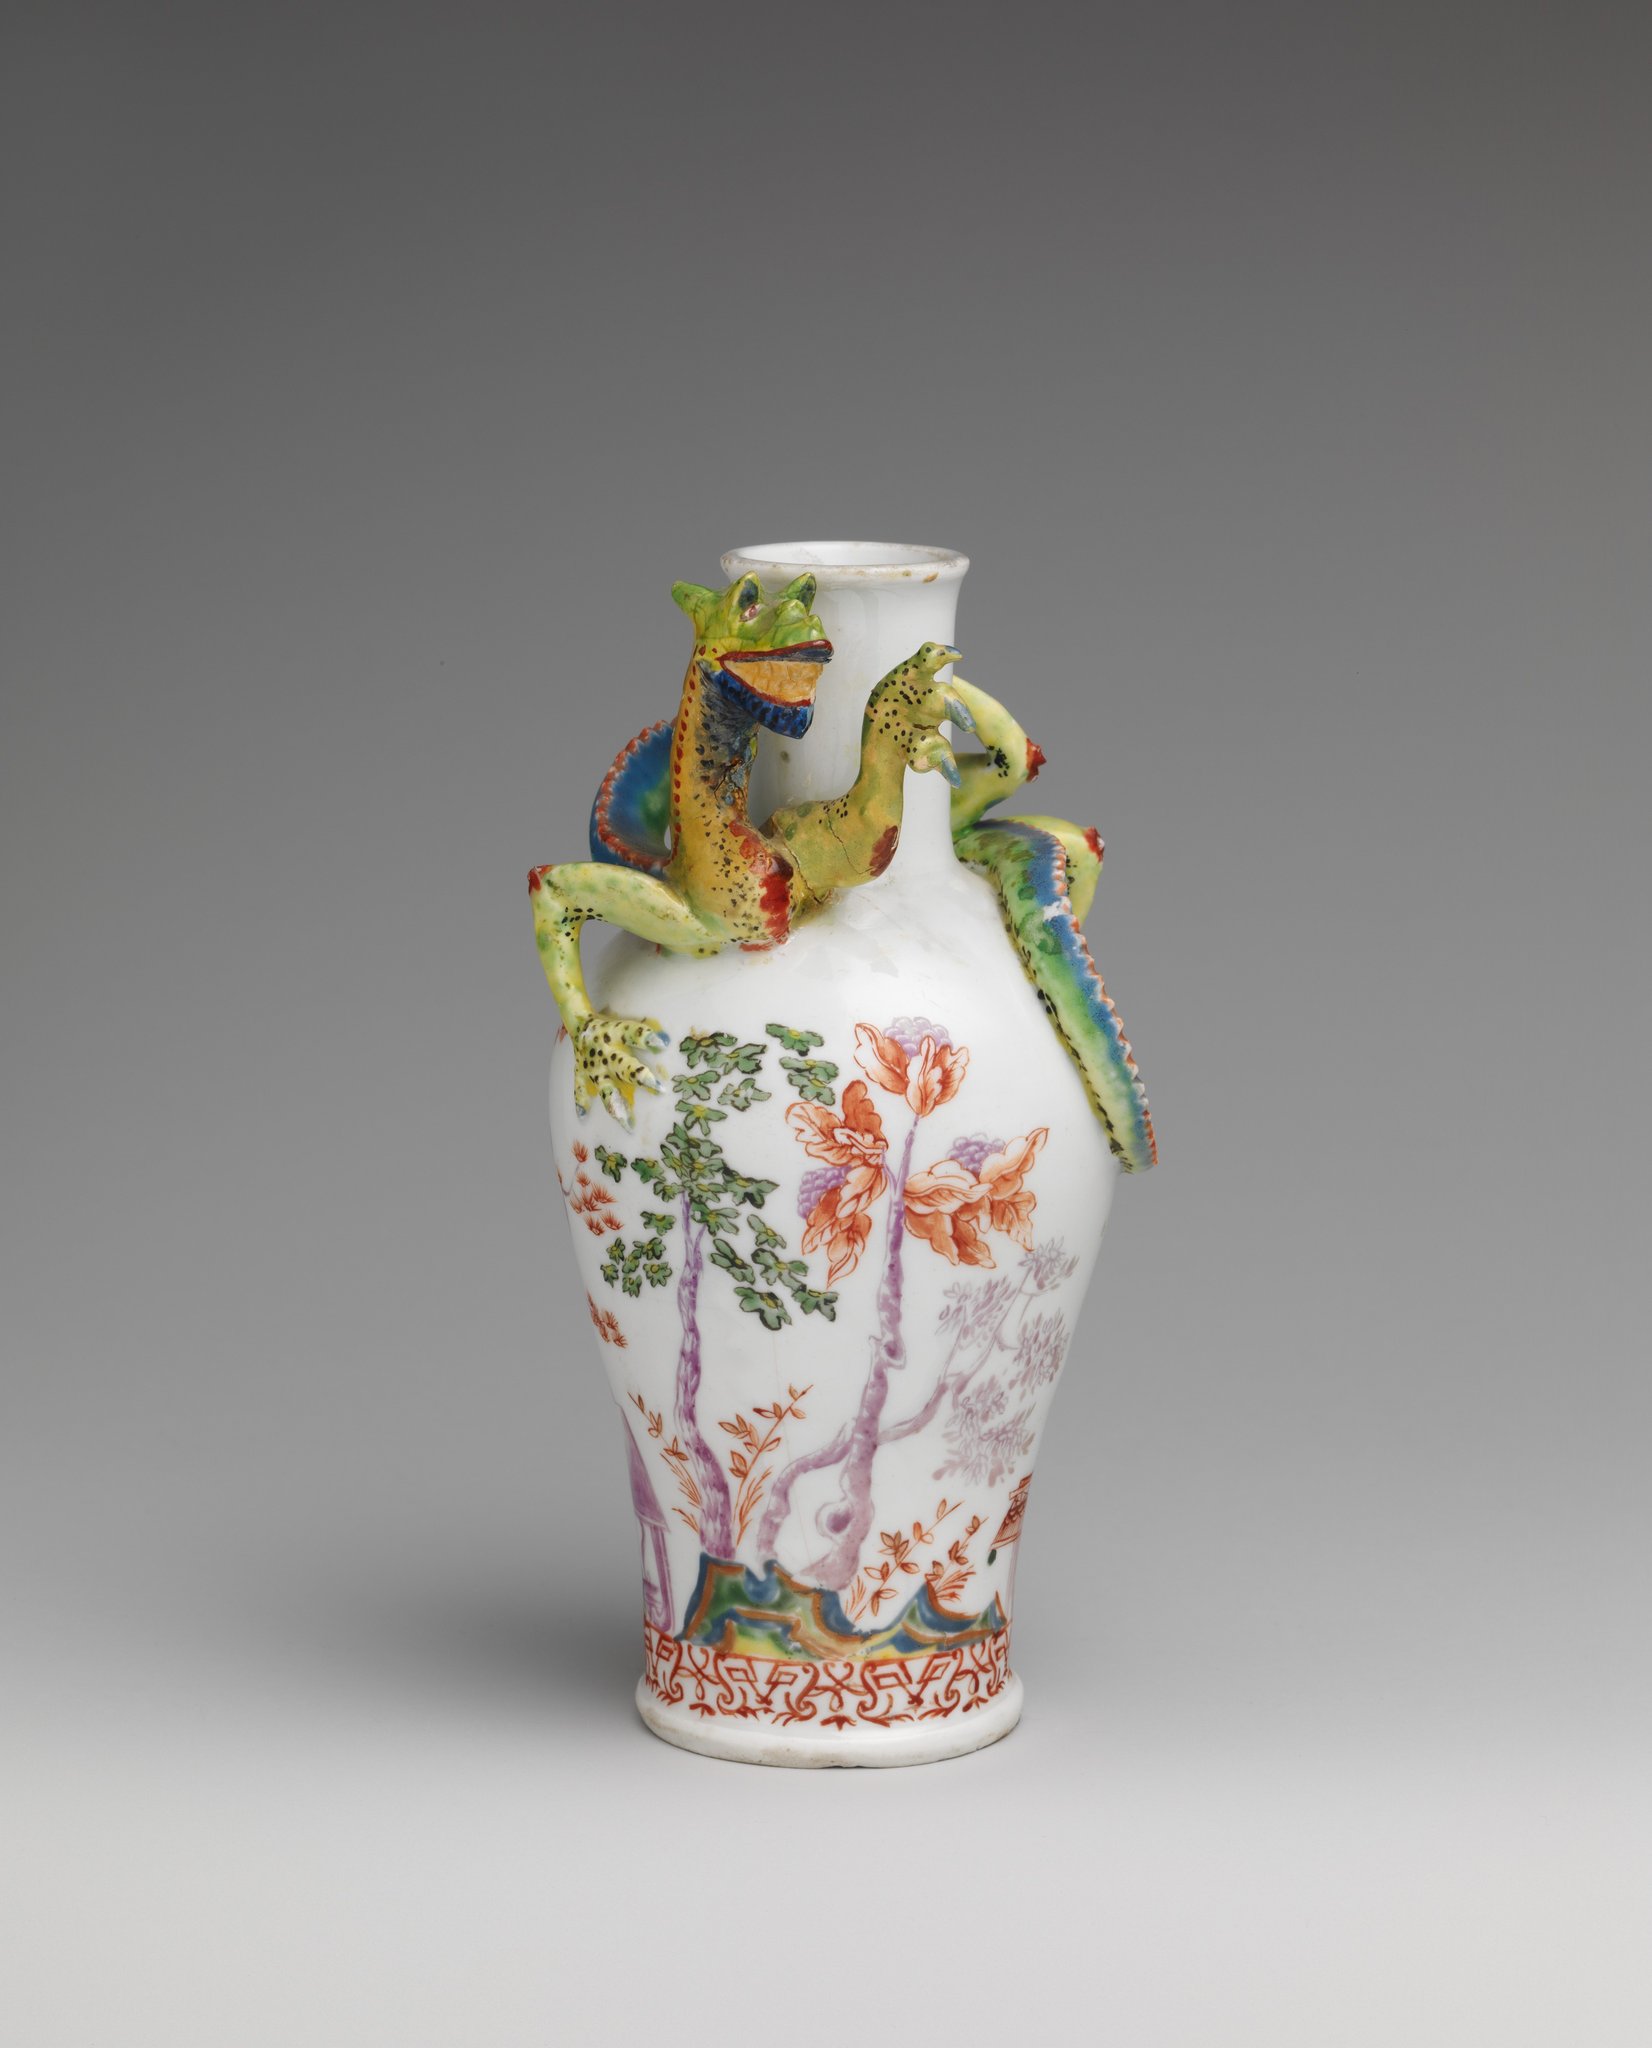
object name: vase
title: Vase (one of a pair)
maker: vienna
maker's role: manufactory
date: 1725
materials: hard paste porcelain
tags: dragons